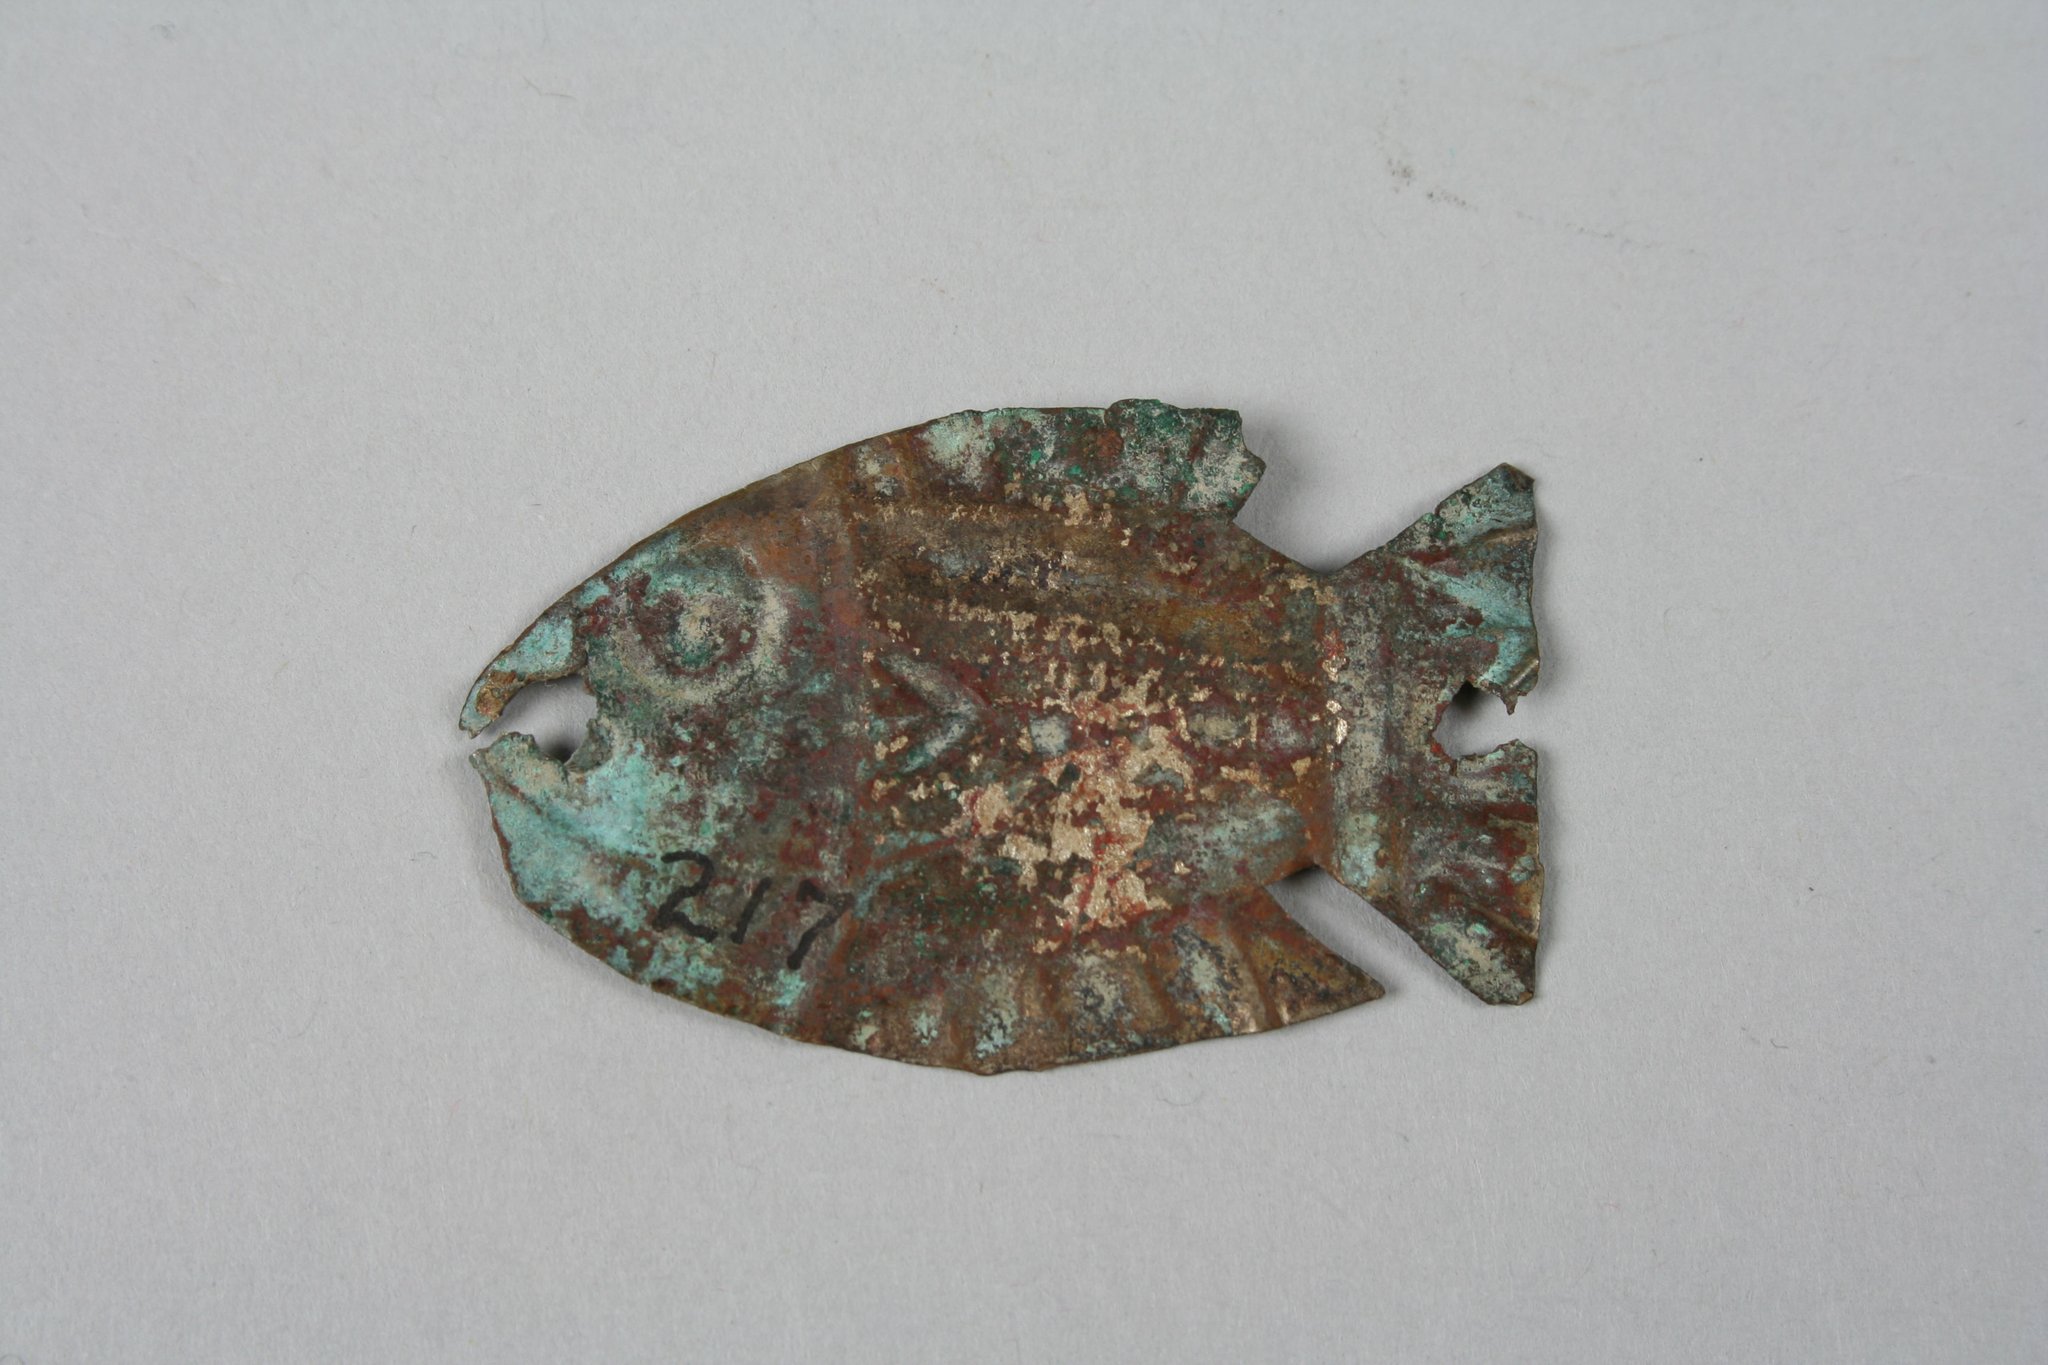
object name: costume ornament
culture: peruvian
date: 1001-1200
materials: silver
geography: peru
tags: fish